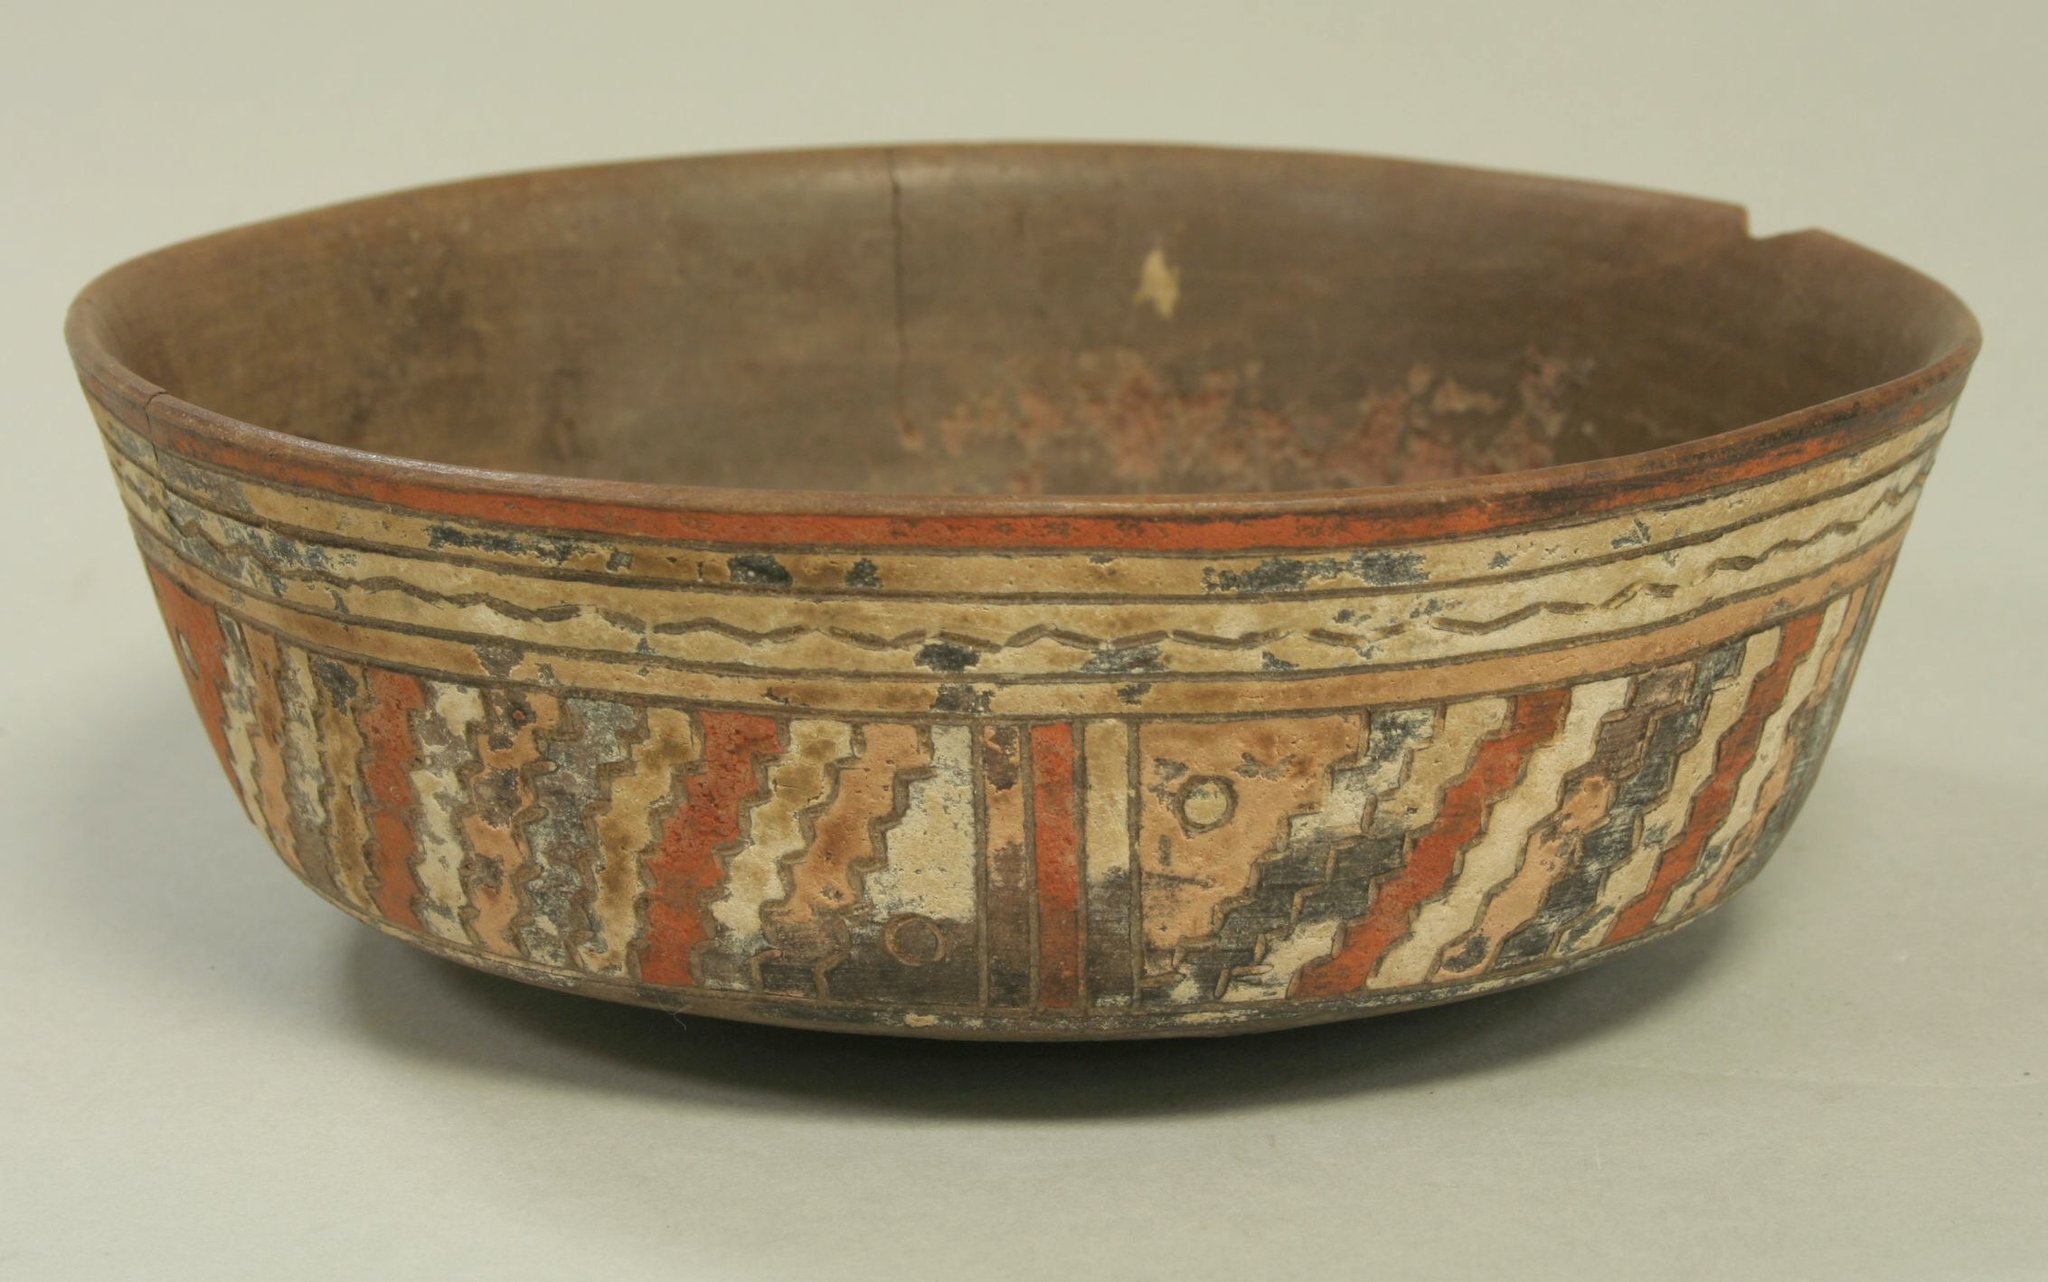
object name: bowl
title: Incised Painted Bowl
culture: paracas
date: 500-101 BCE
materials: ceramic, pigment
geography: peru